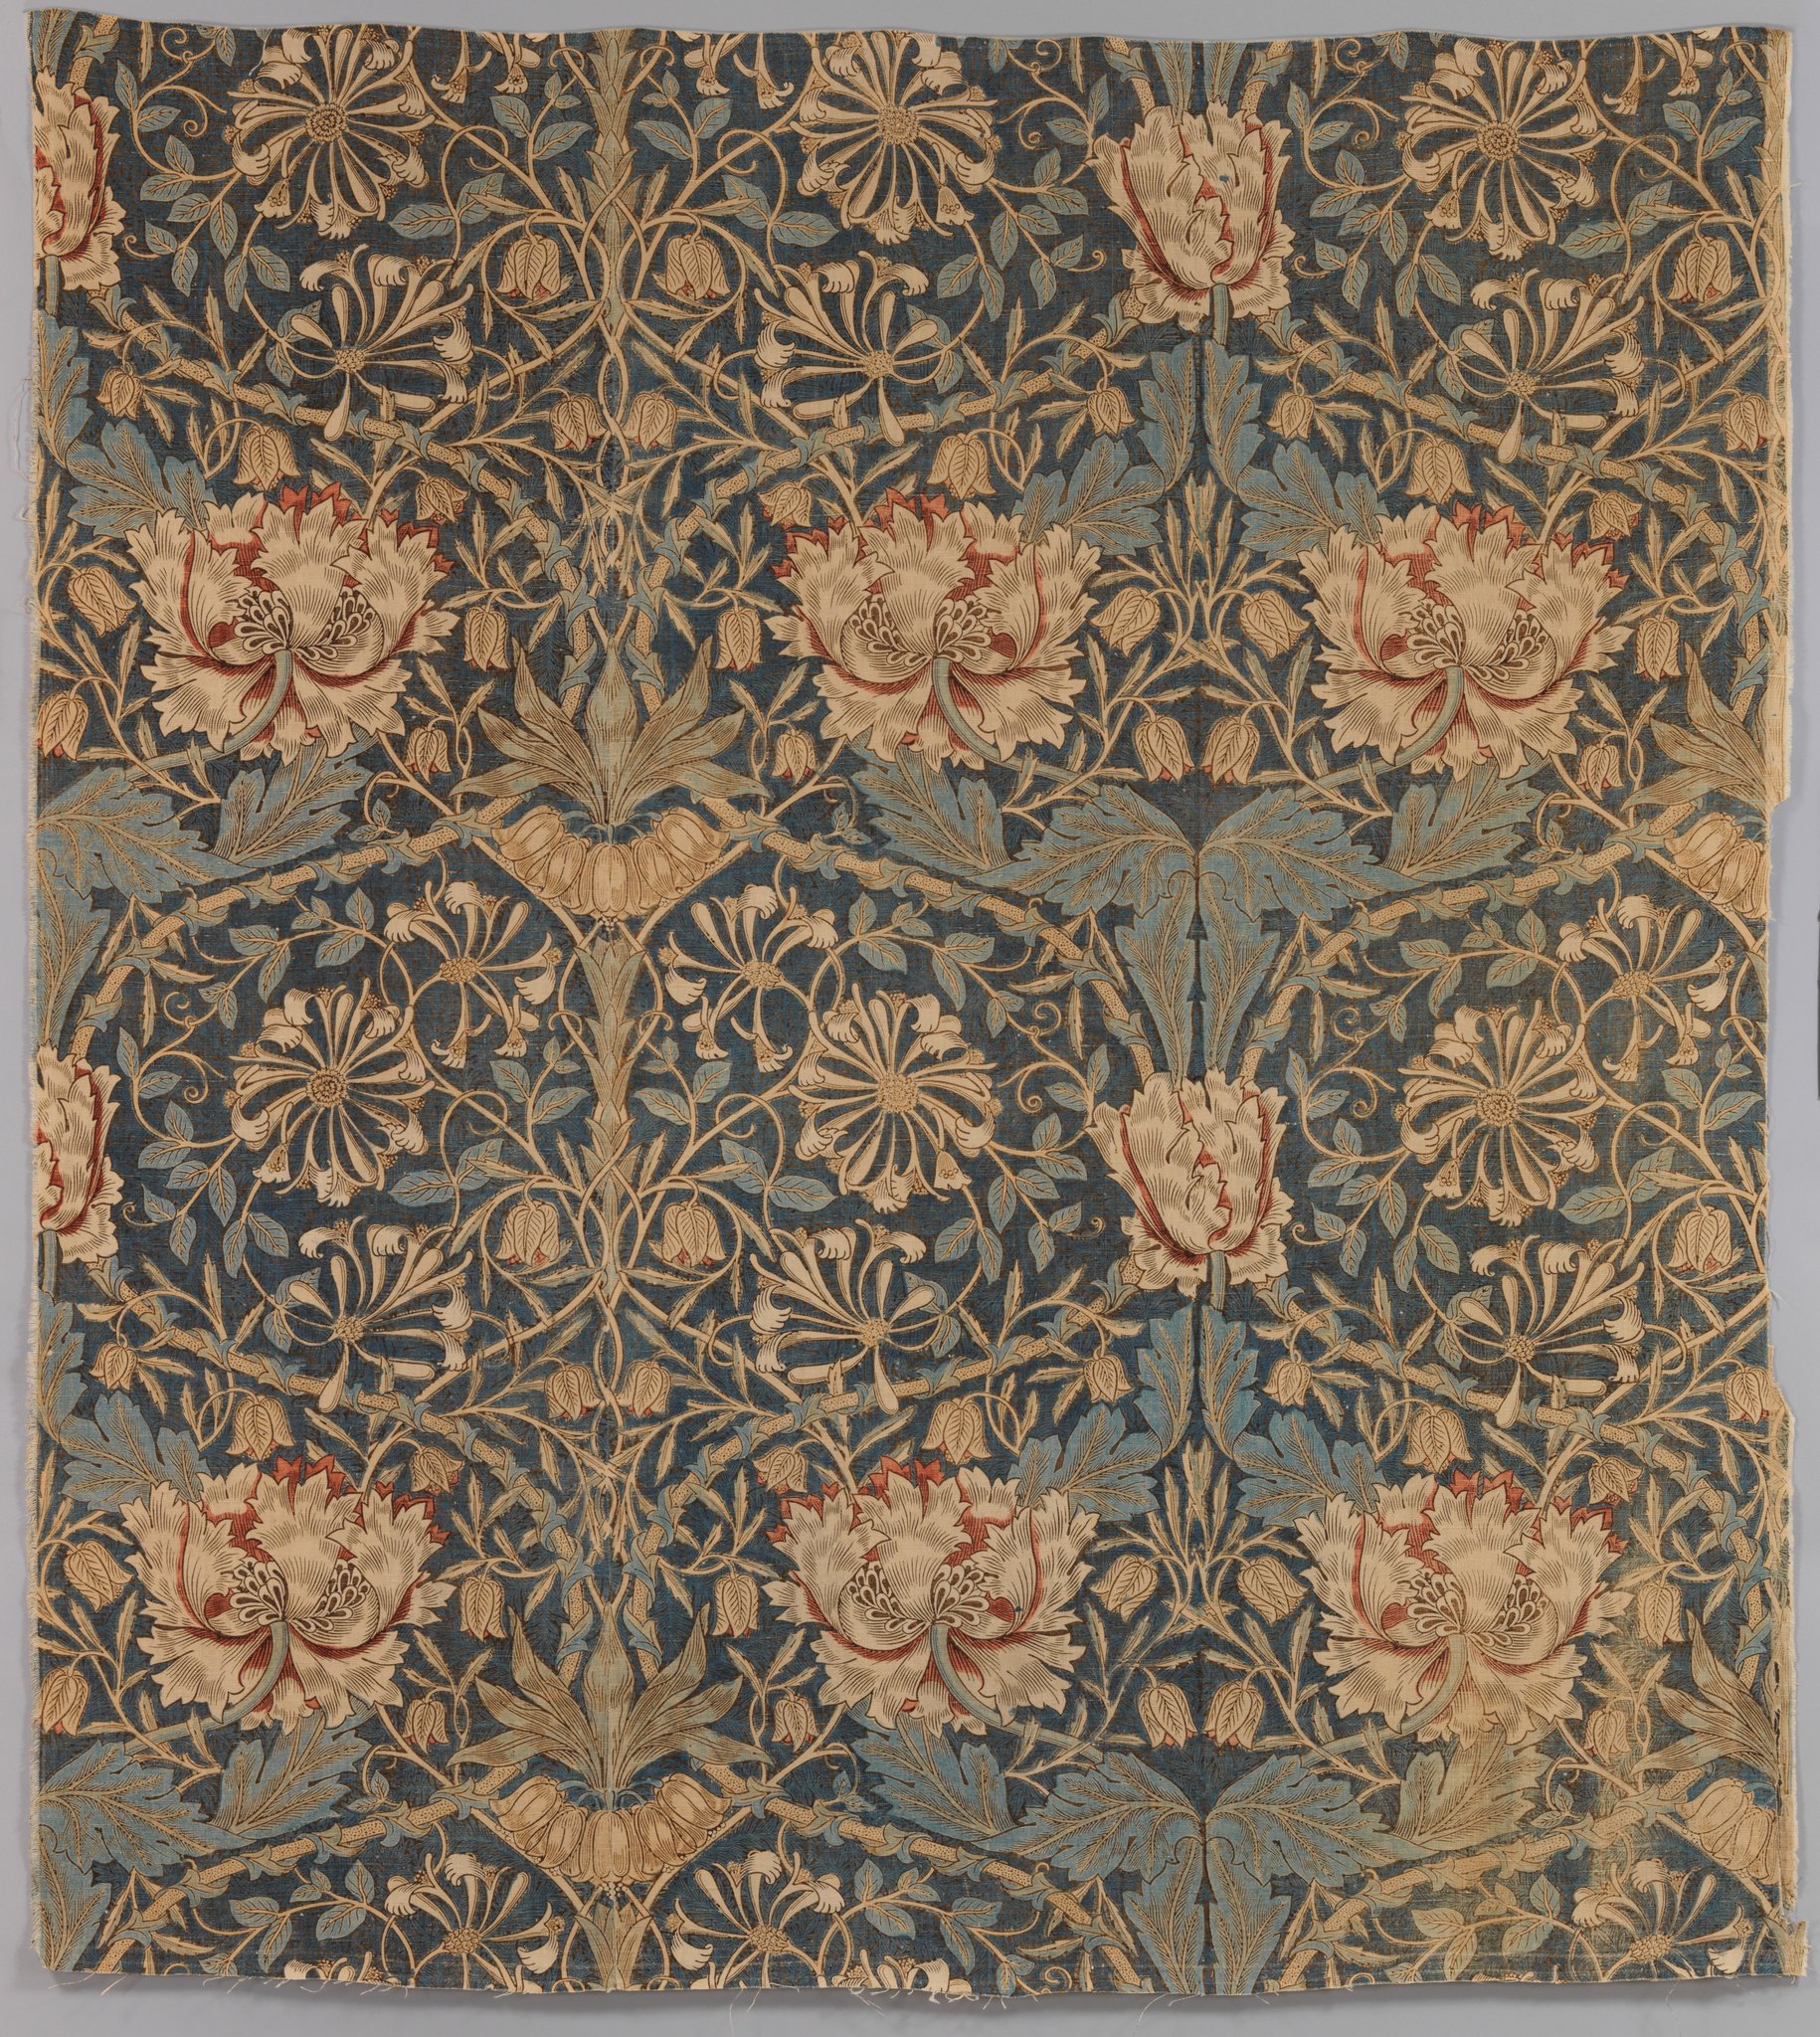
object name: furnishing textile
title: Honeysuckle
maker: william morris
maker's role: designer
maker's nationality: british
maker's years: 1834-1896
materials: linen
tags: flowers